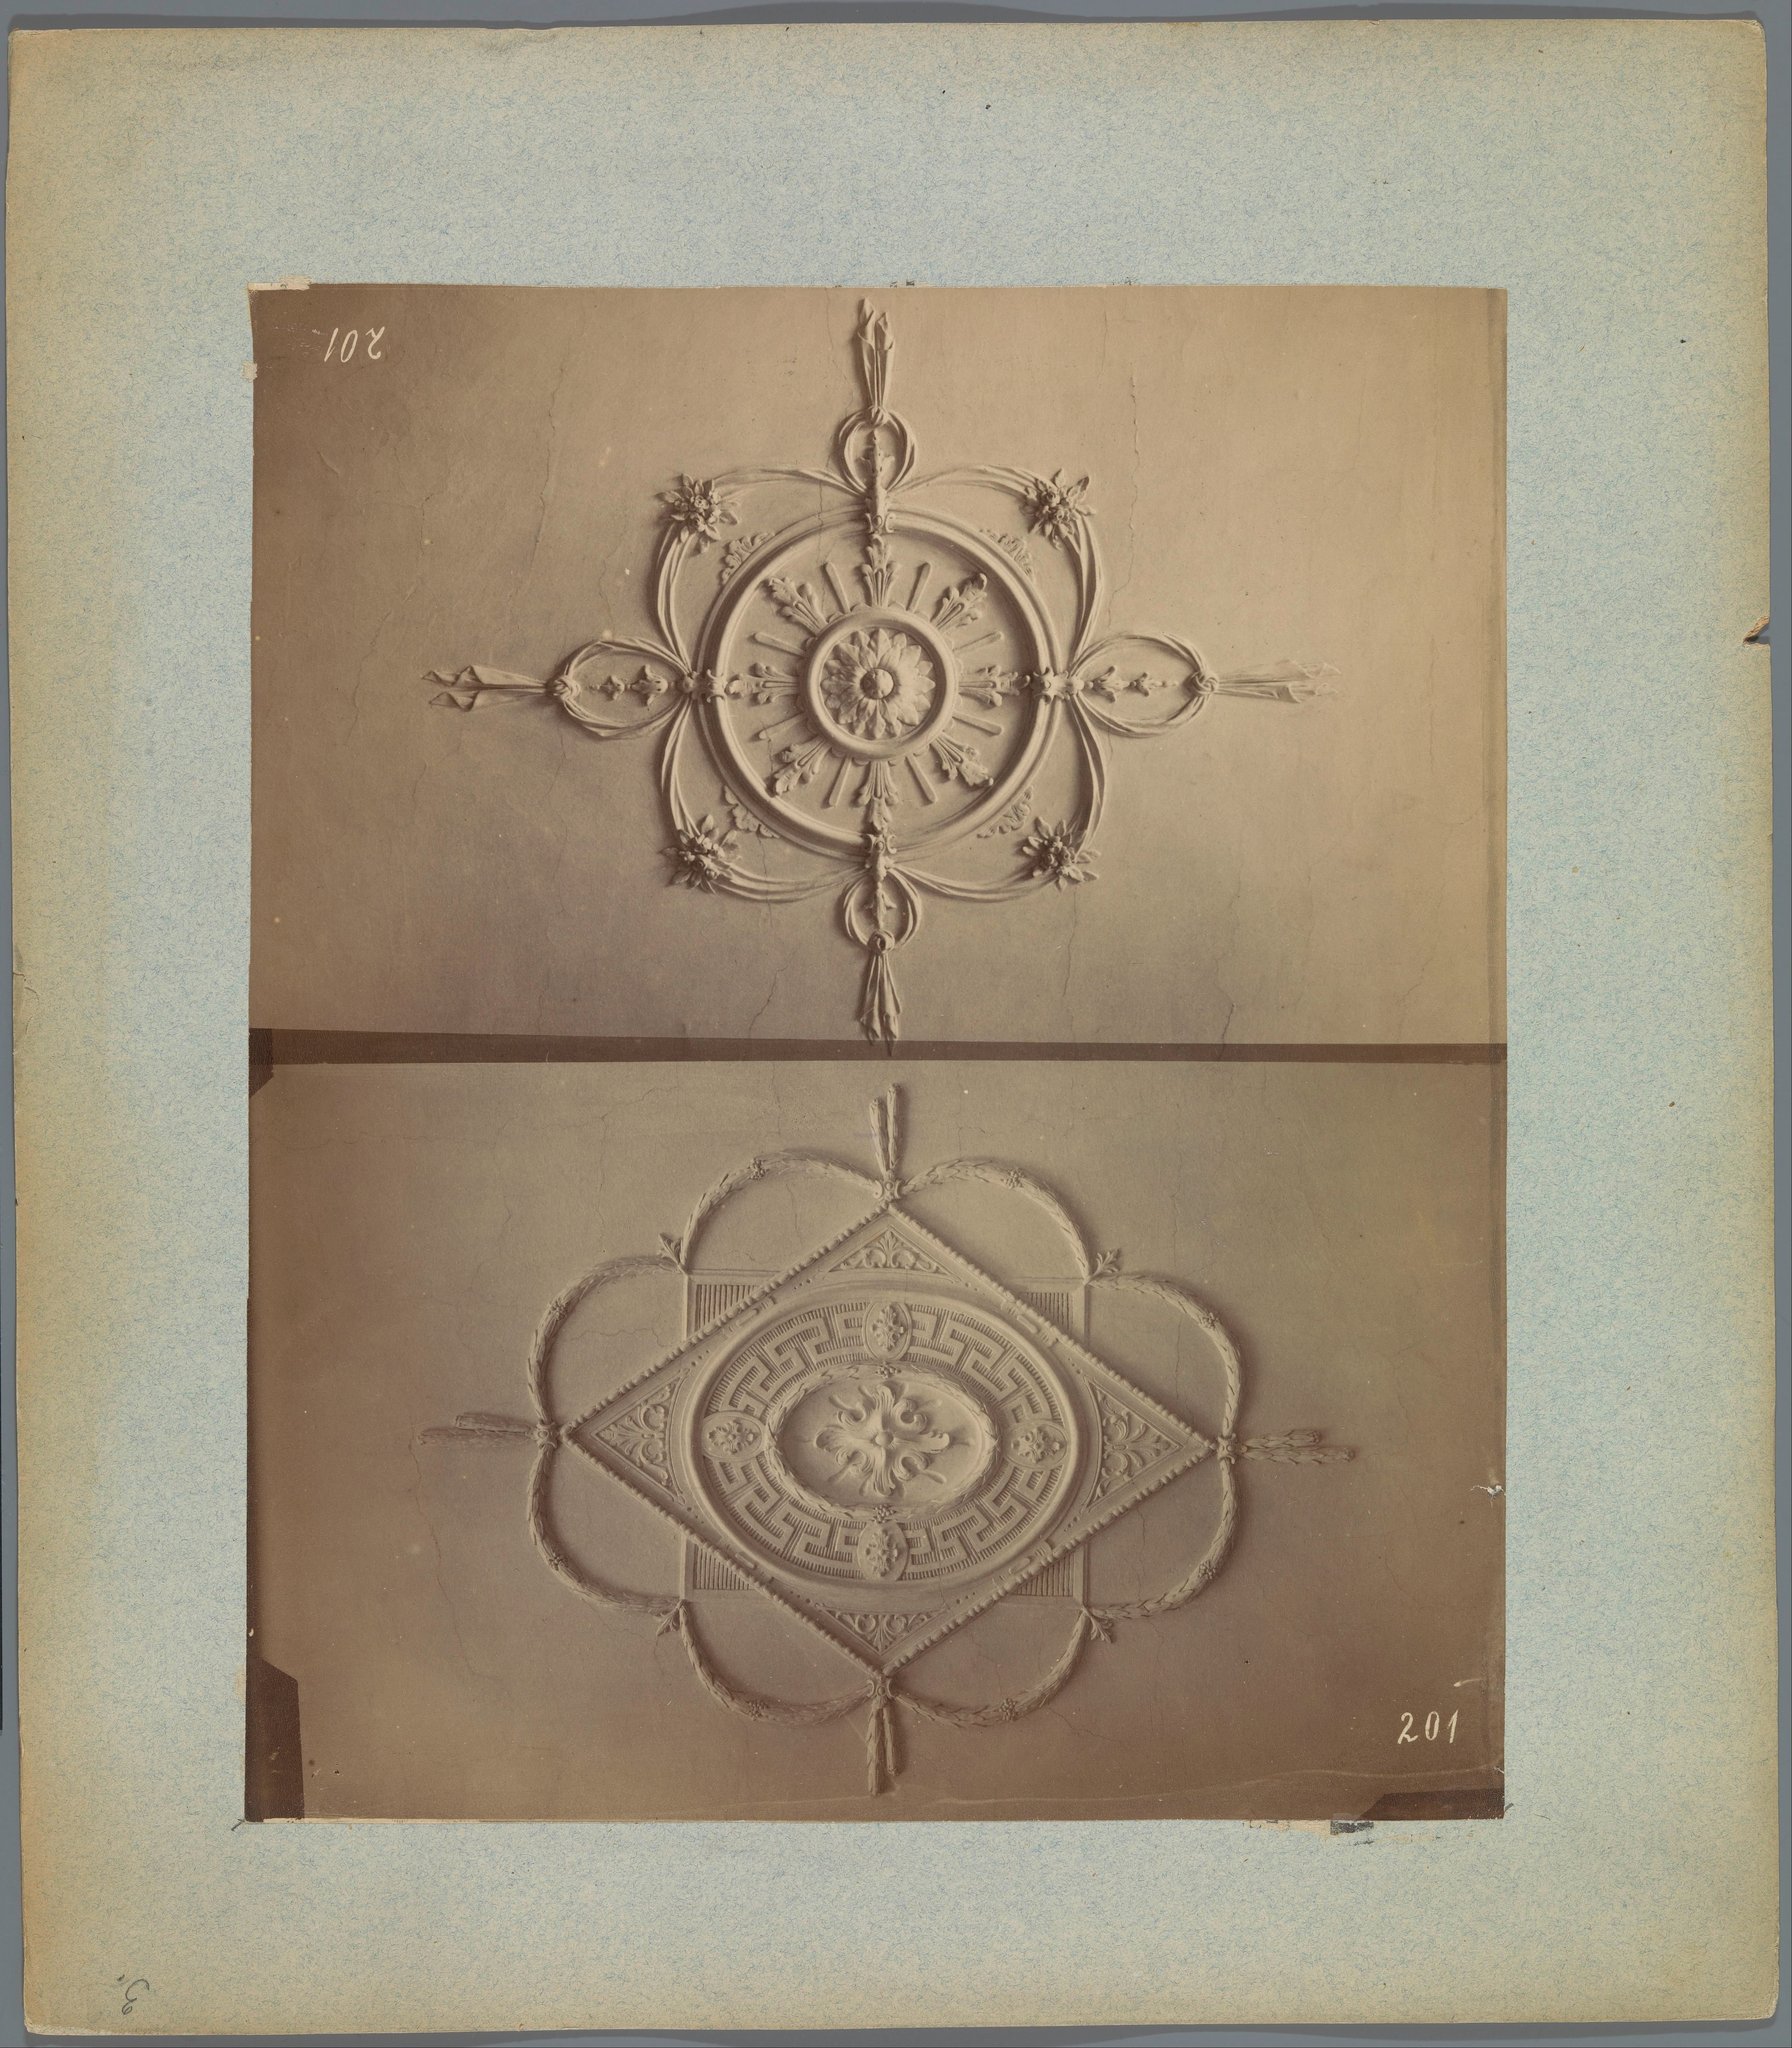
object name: photograph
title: Overzicht van twee reliëfs, mogelijk uit Schloss Bruchsal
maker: Anonymous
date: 1875-1900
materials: cardboard, photographic support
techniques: albumen print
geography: europe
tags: ornament derived from plant forms, flowers ~ ornament, sculpture (+ relief ~ sculpture), europe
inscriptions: number: ‘201’, collector's mark: ‘RIJKS-NORMAALSCHOOL-VOOR-TEEKENONDERWIJZERS-AMSTERDAM’, inscription: ‘Bruchsall’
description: Boven een ruitvormig relïef met guirlandes eromheen, onder een relïef met bloemmotief.